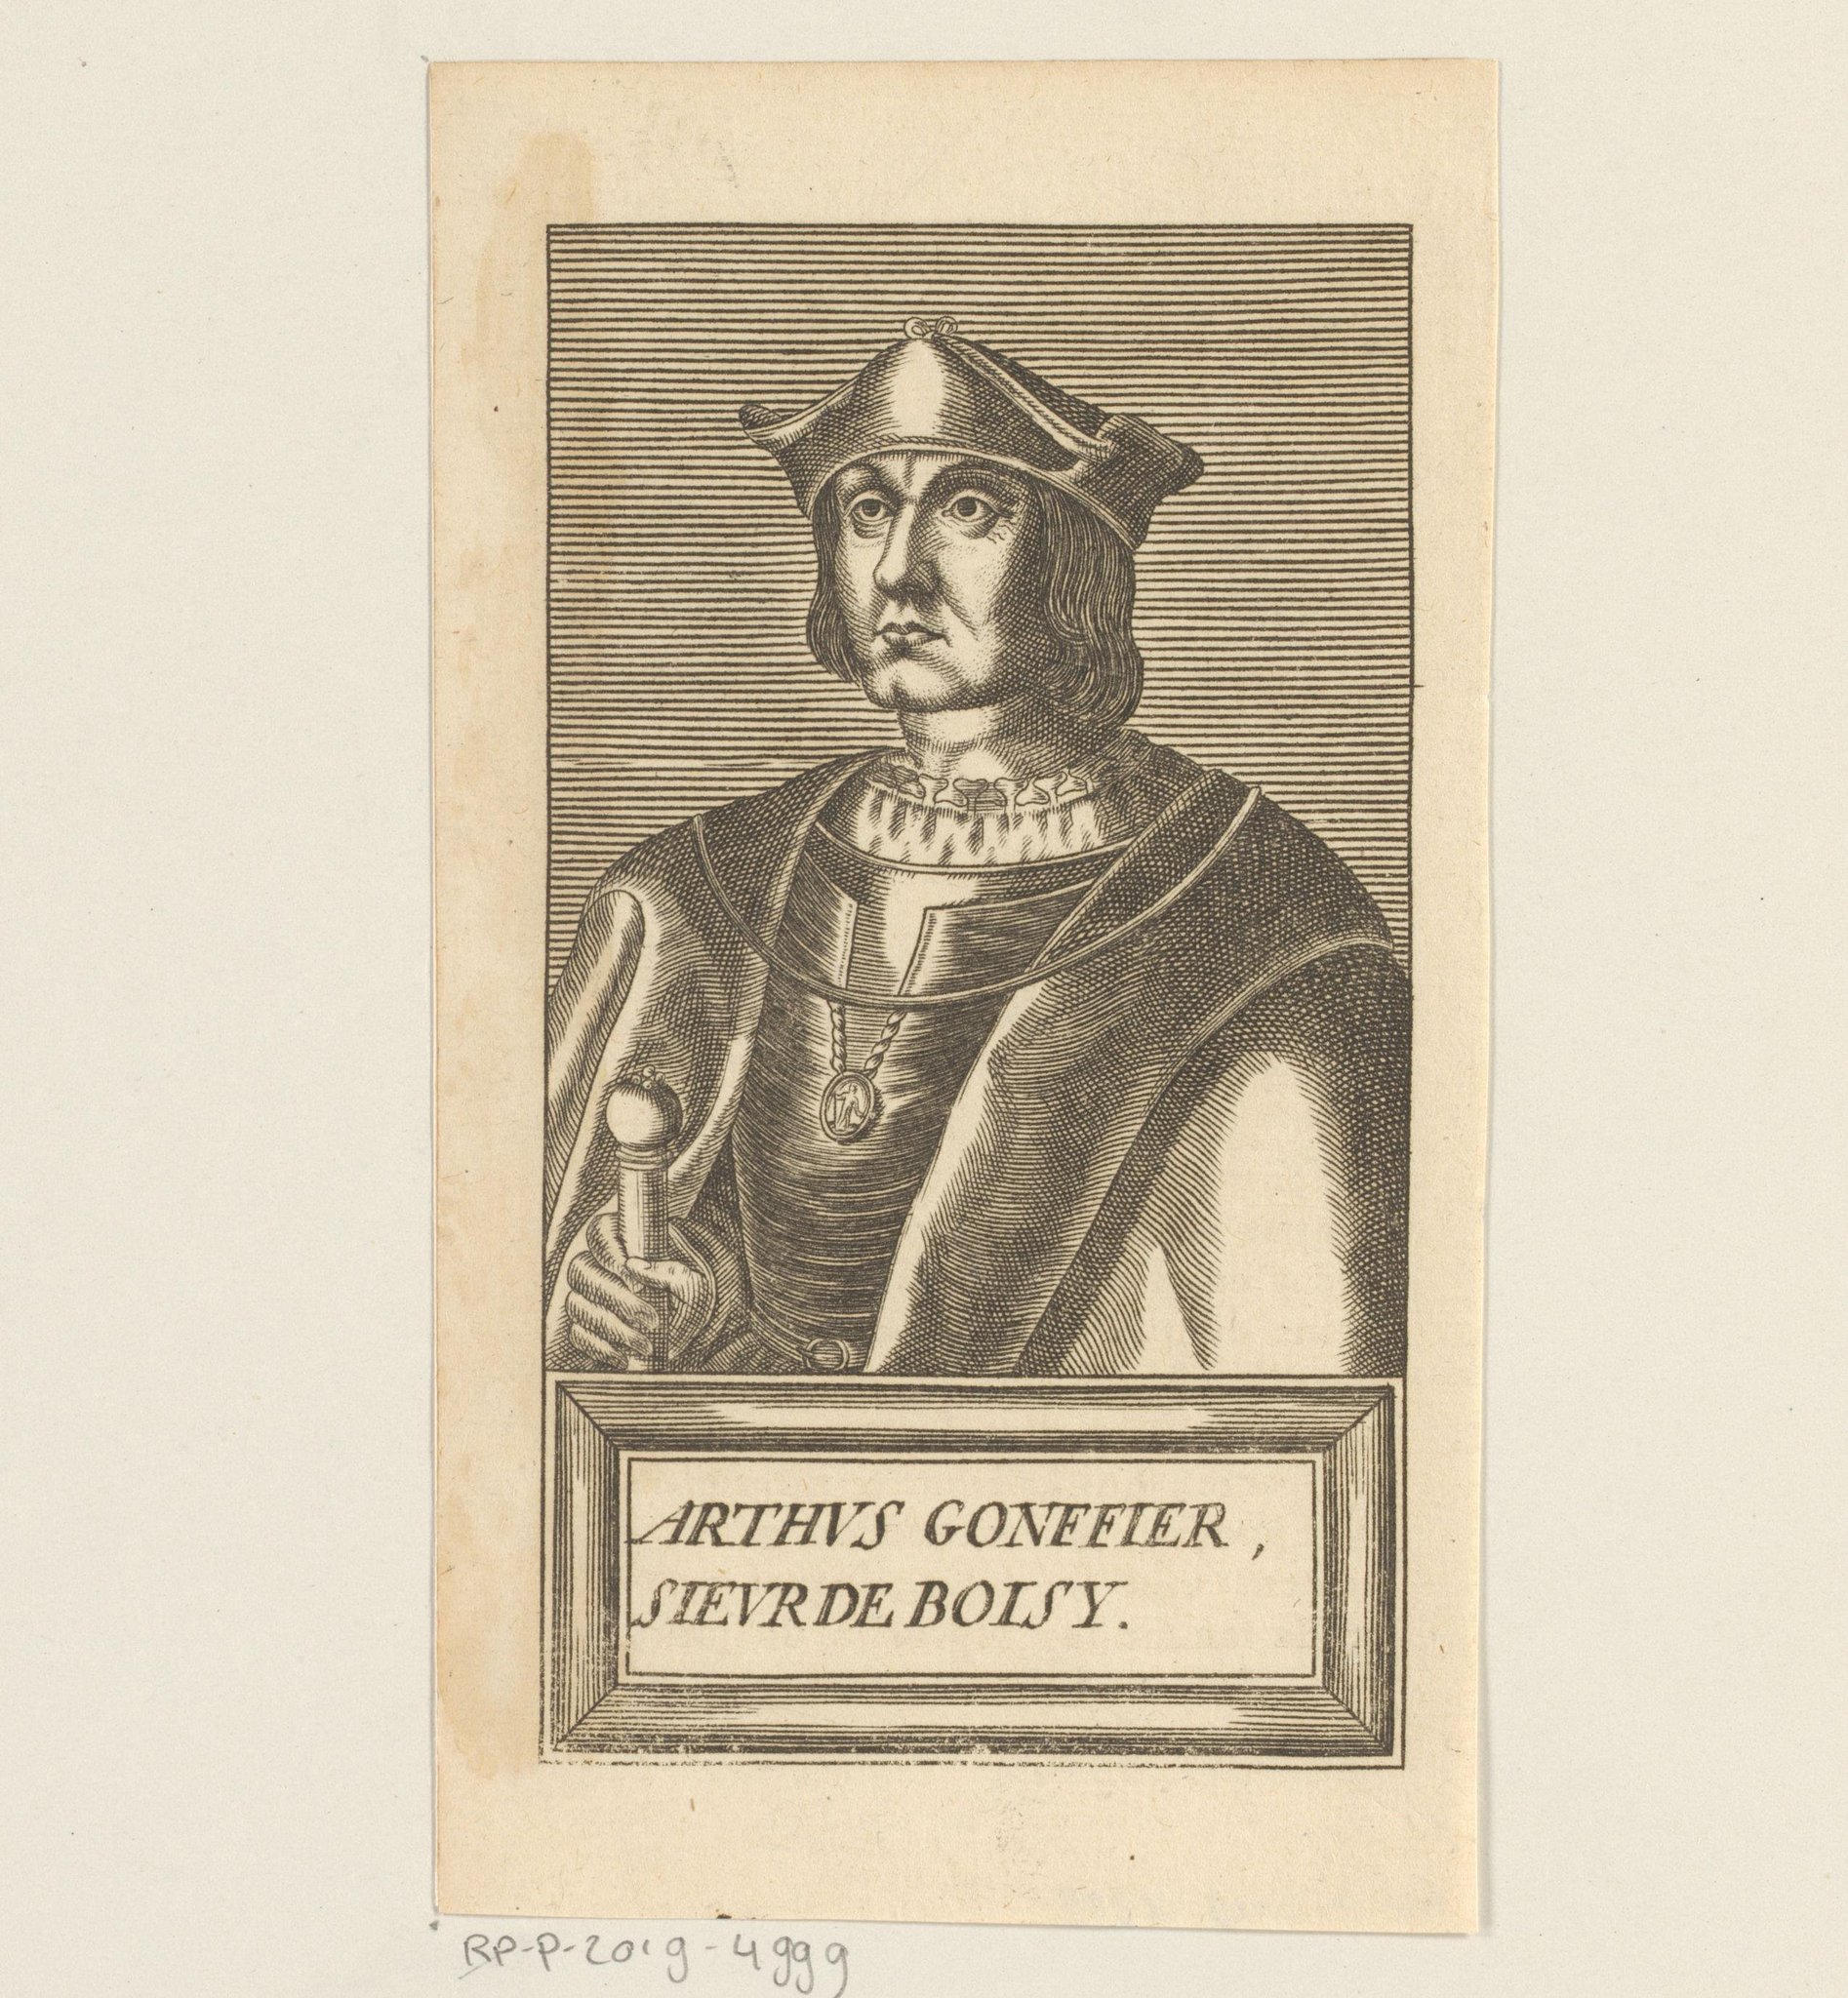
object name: print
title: Portret van Artus Gouffier de Boisy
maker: Anonymous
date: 1600-1649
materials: paper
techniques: engraving, etching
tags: politician, artus gouffier, historical persons